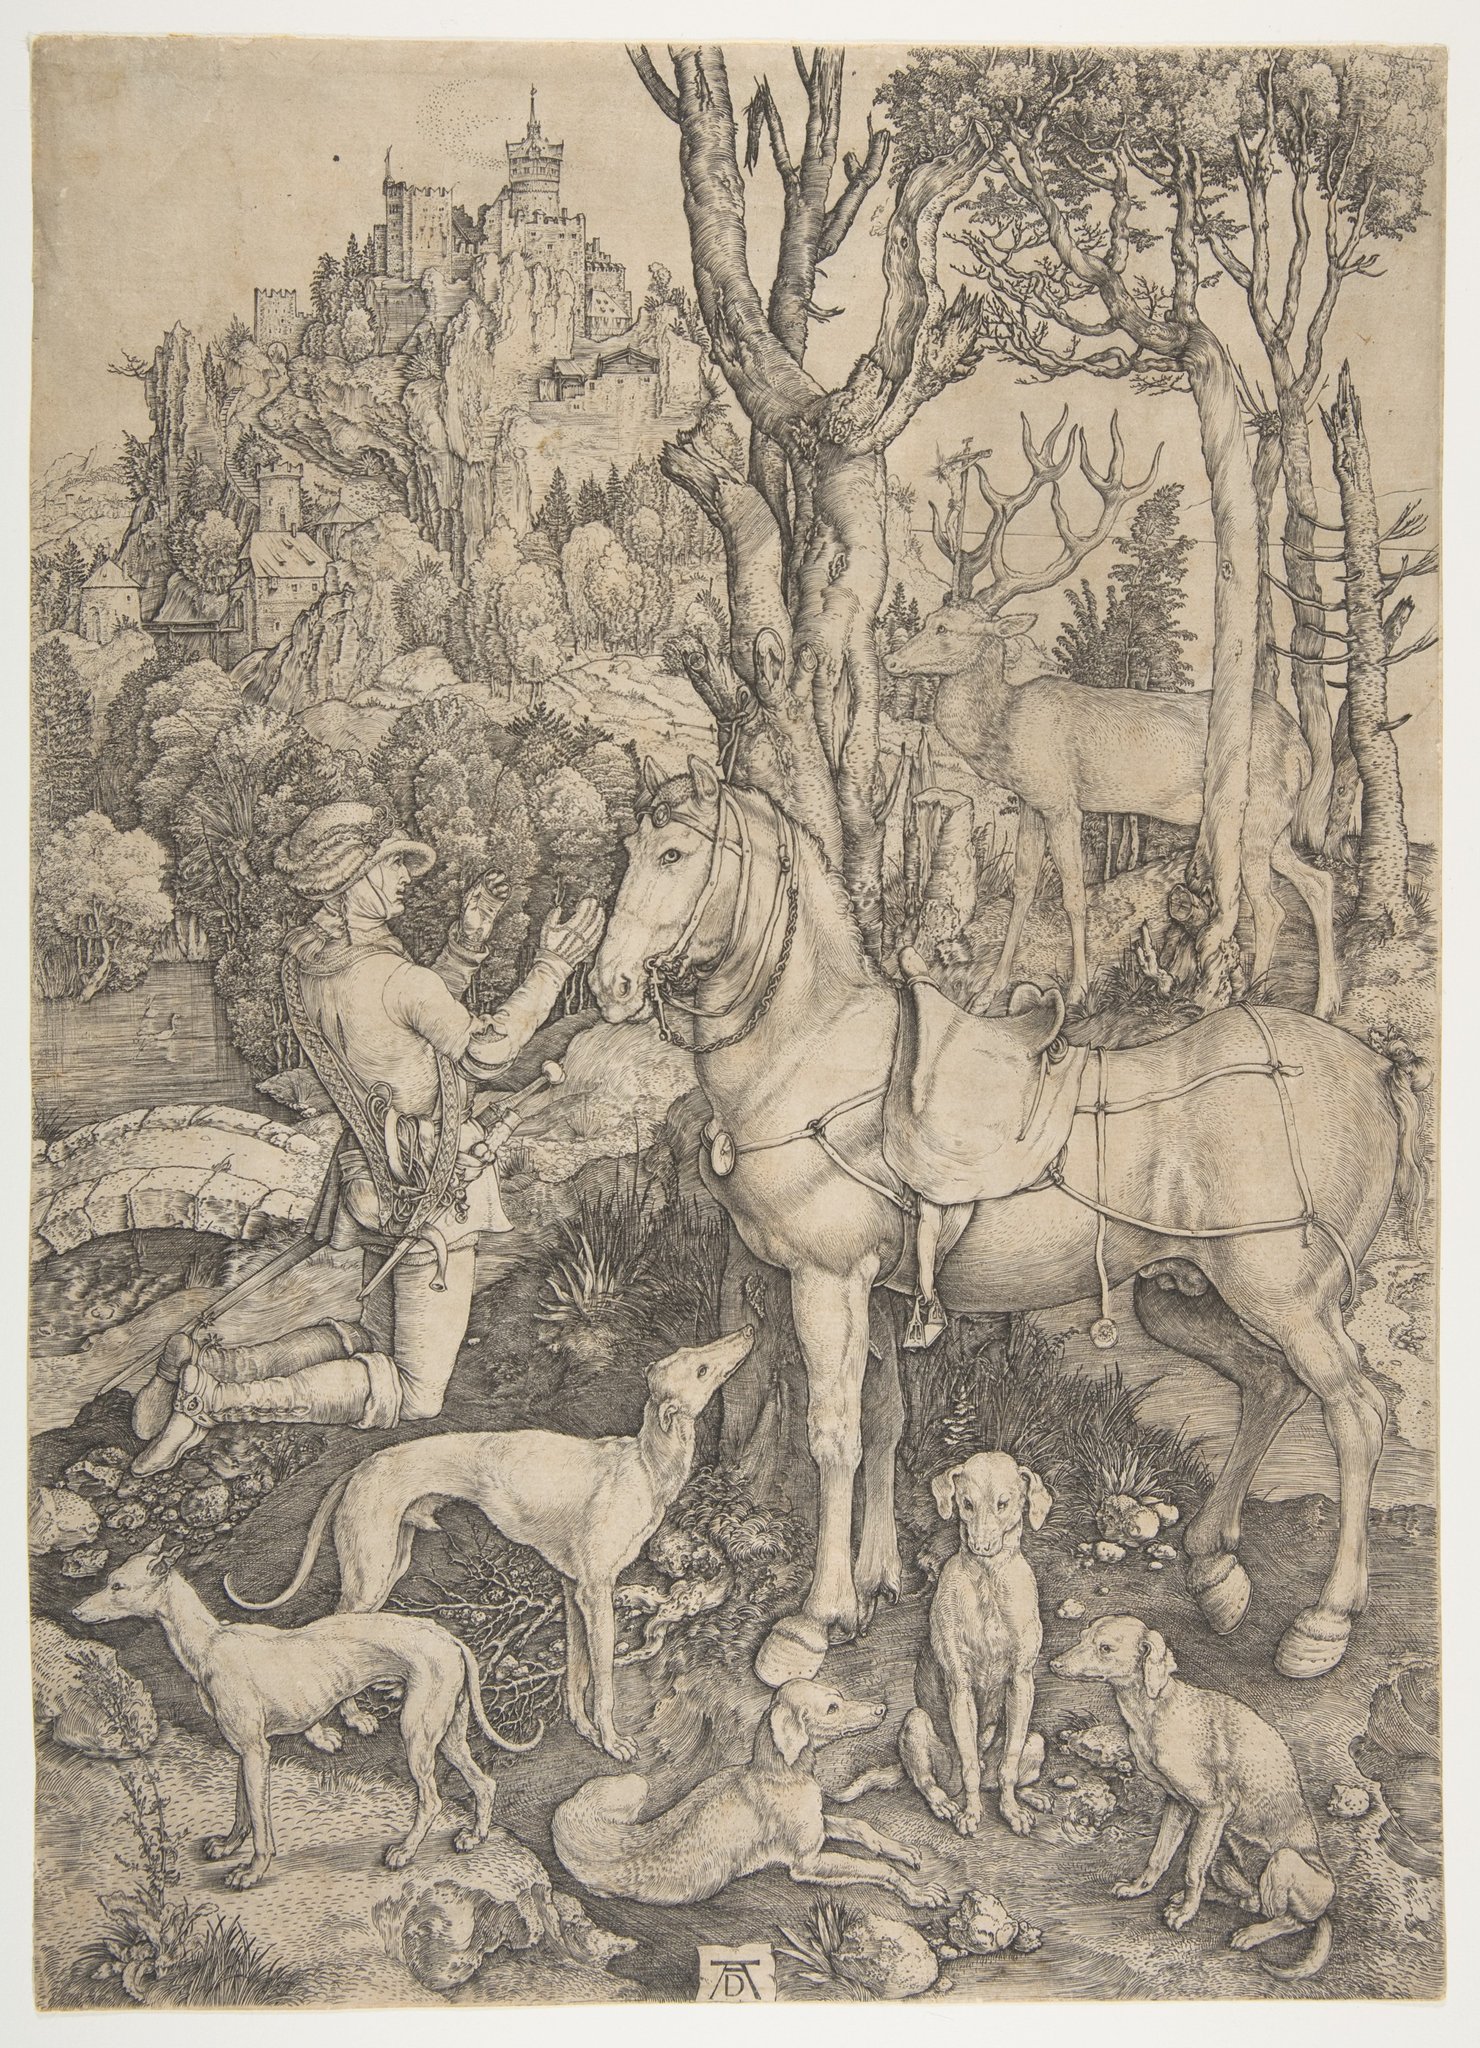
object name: print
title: Saint Eustace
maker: albrecht dürer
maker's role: artist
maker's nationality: german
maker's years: 1471-1528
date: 1501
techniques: engraving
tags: deer,dogs,horses,saints